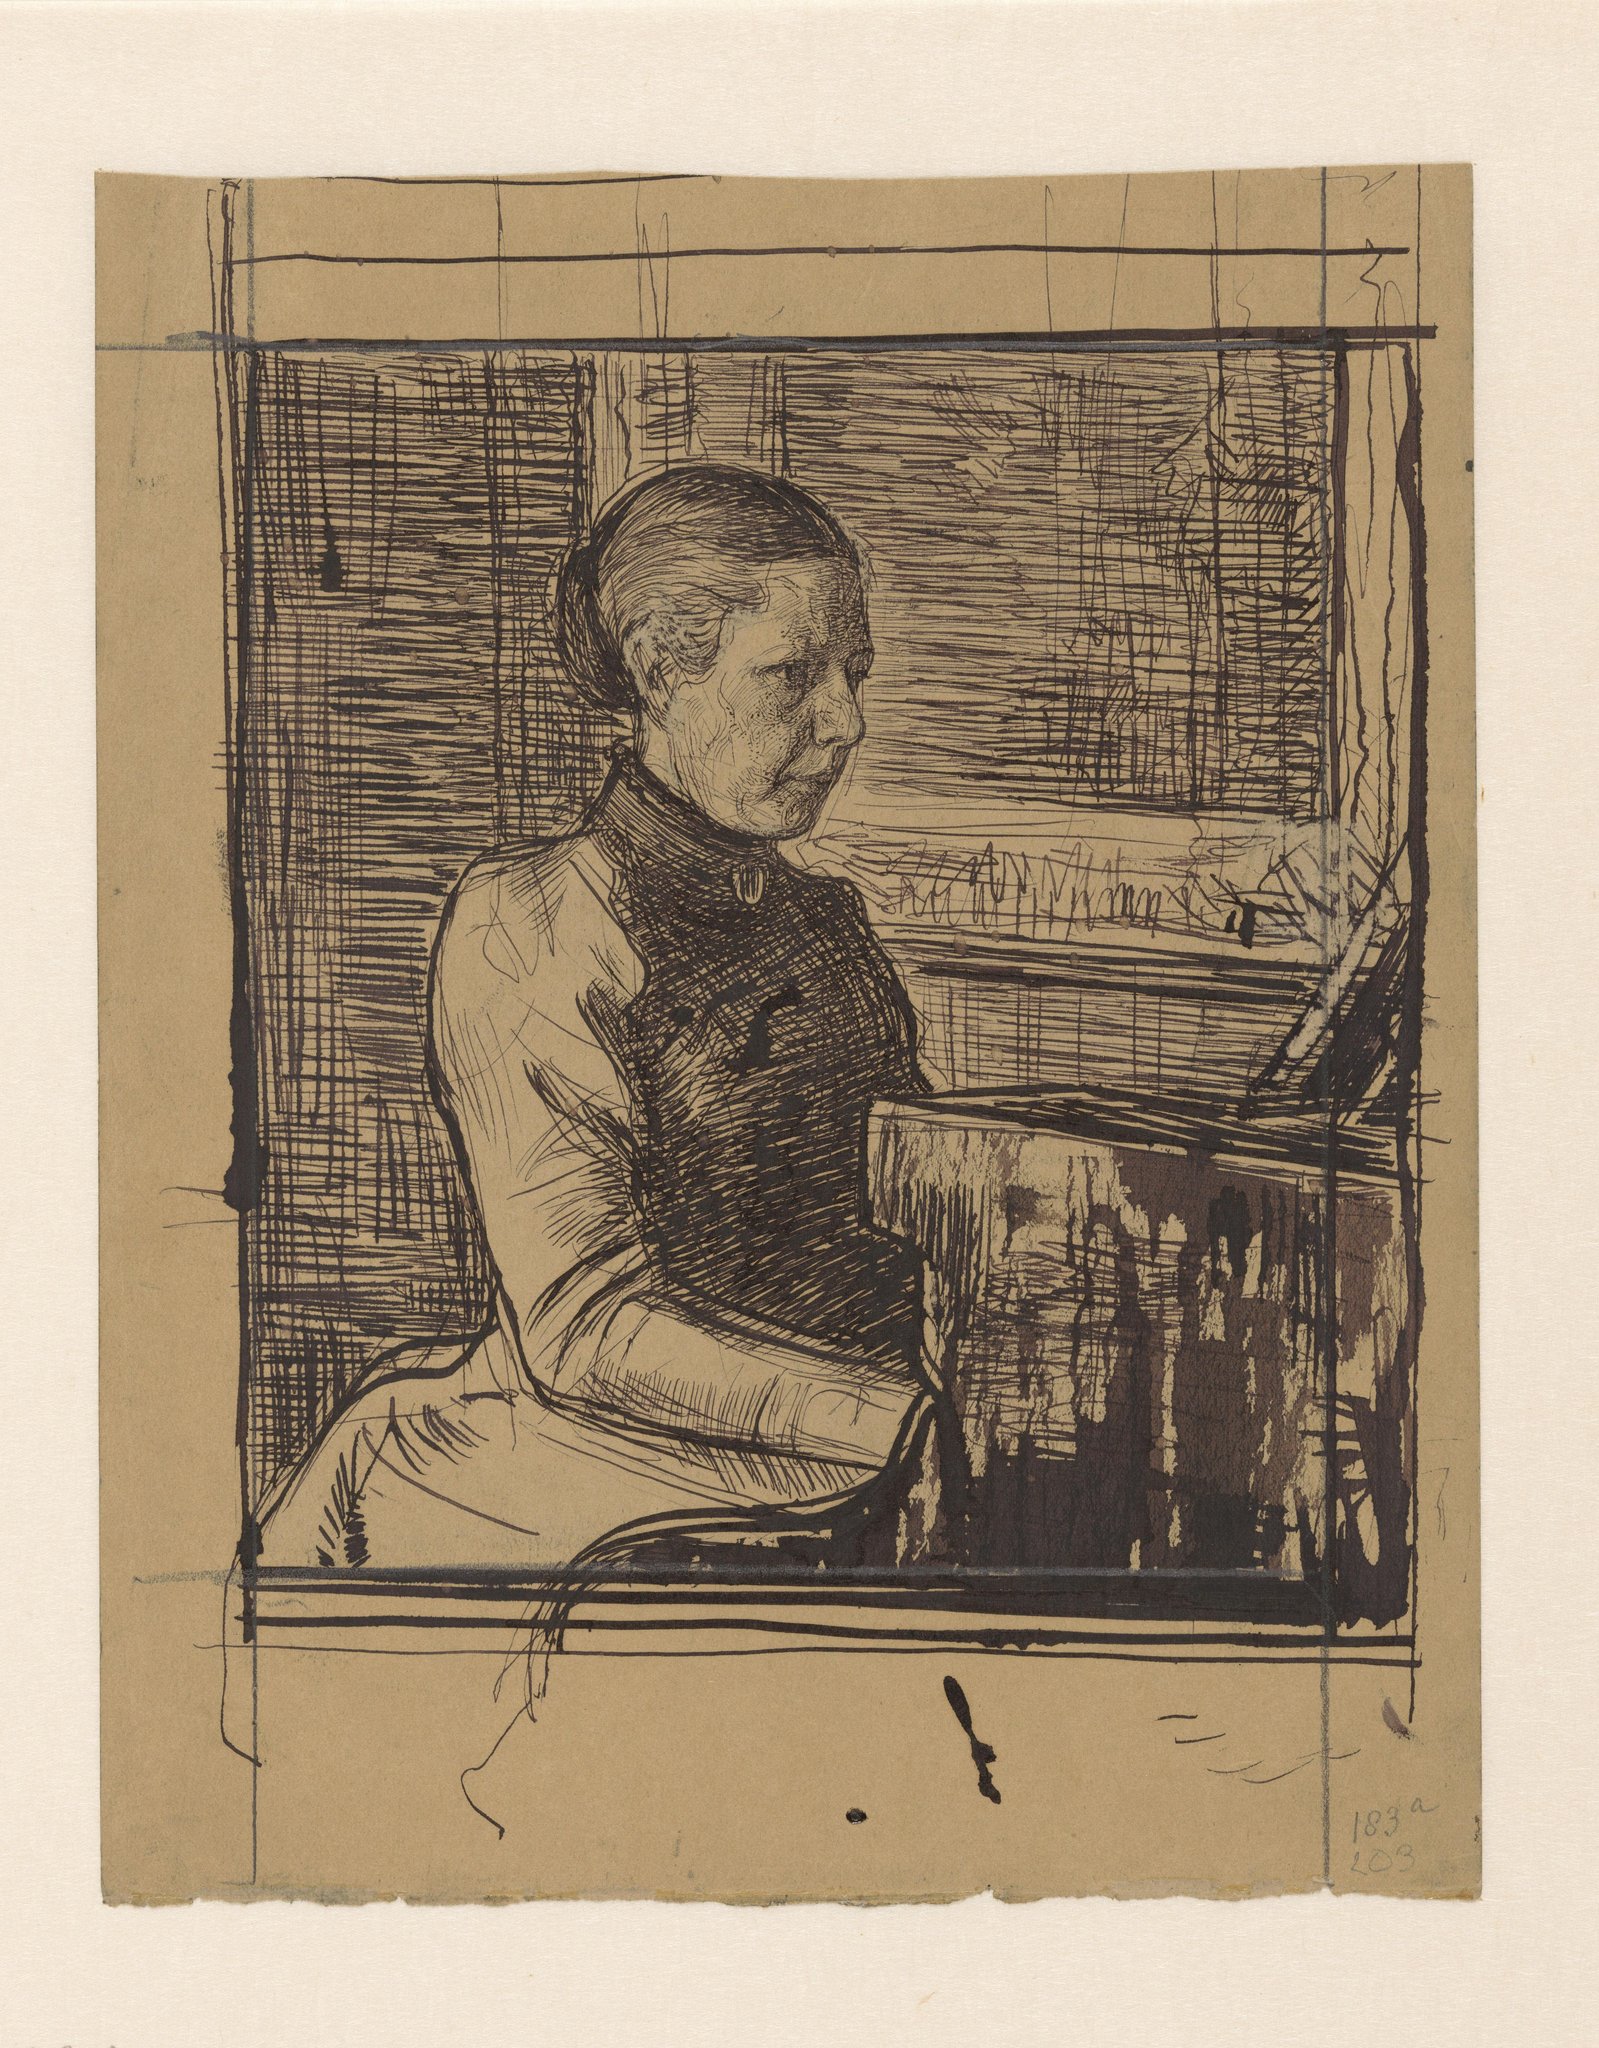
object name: drawing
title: Portret van mevrouw Van Marken-Matthes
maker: jan veth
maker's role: designer, draughtsman, painter, print maker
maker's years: 1864-1925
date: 1874-1925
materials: ink, paper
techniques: pen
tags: one person playing keyboard instrument, historical persons, pianoforte